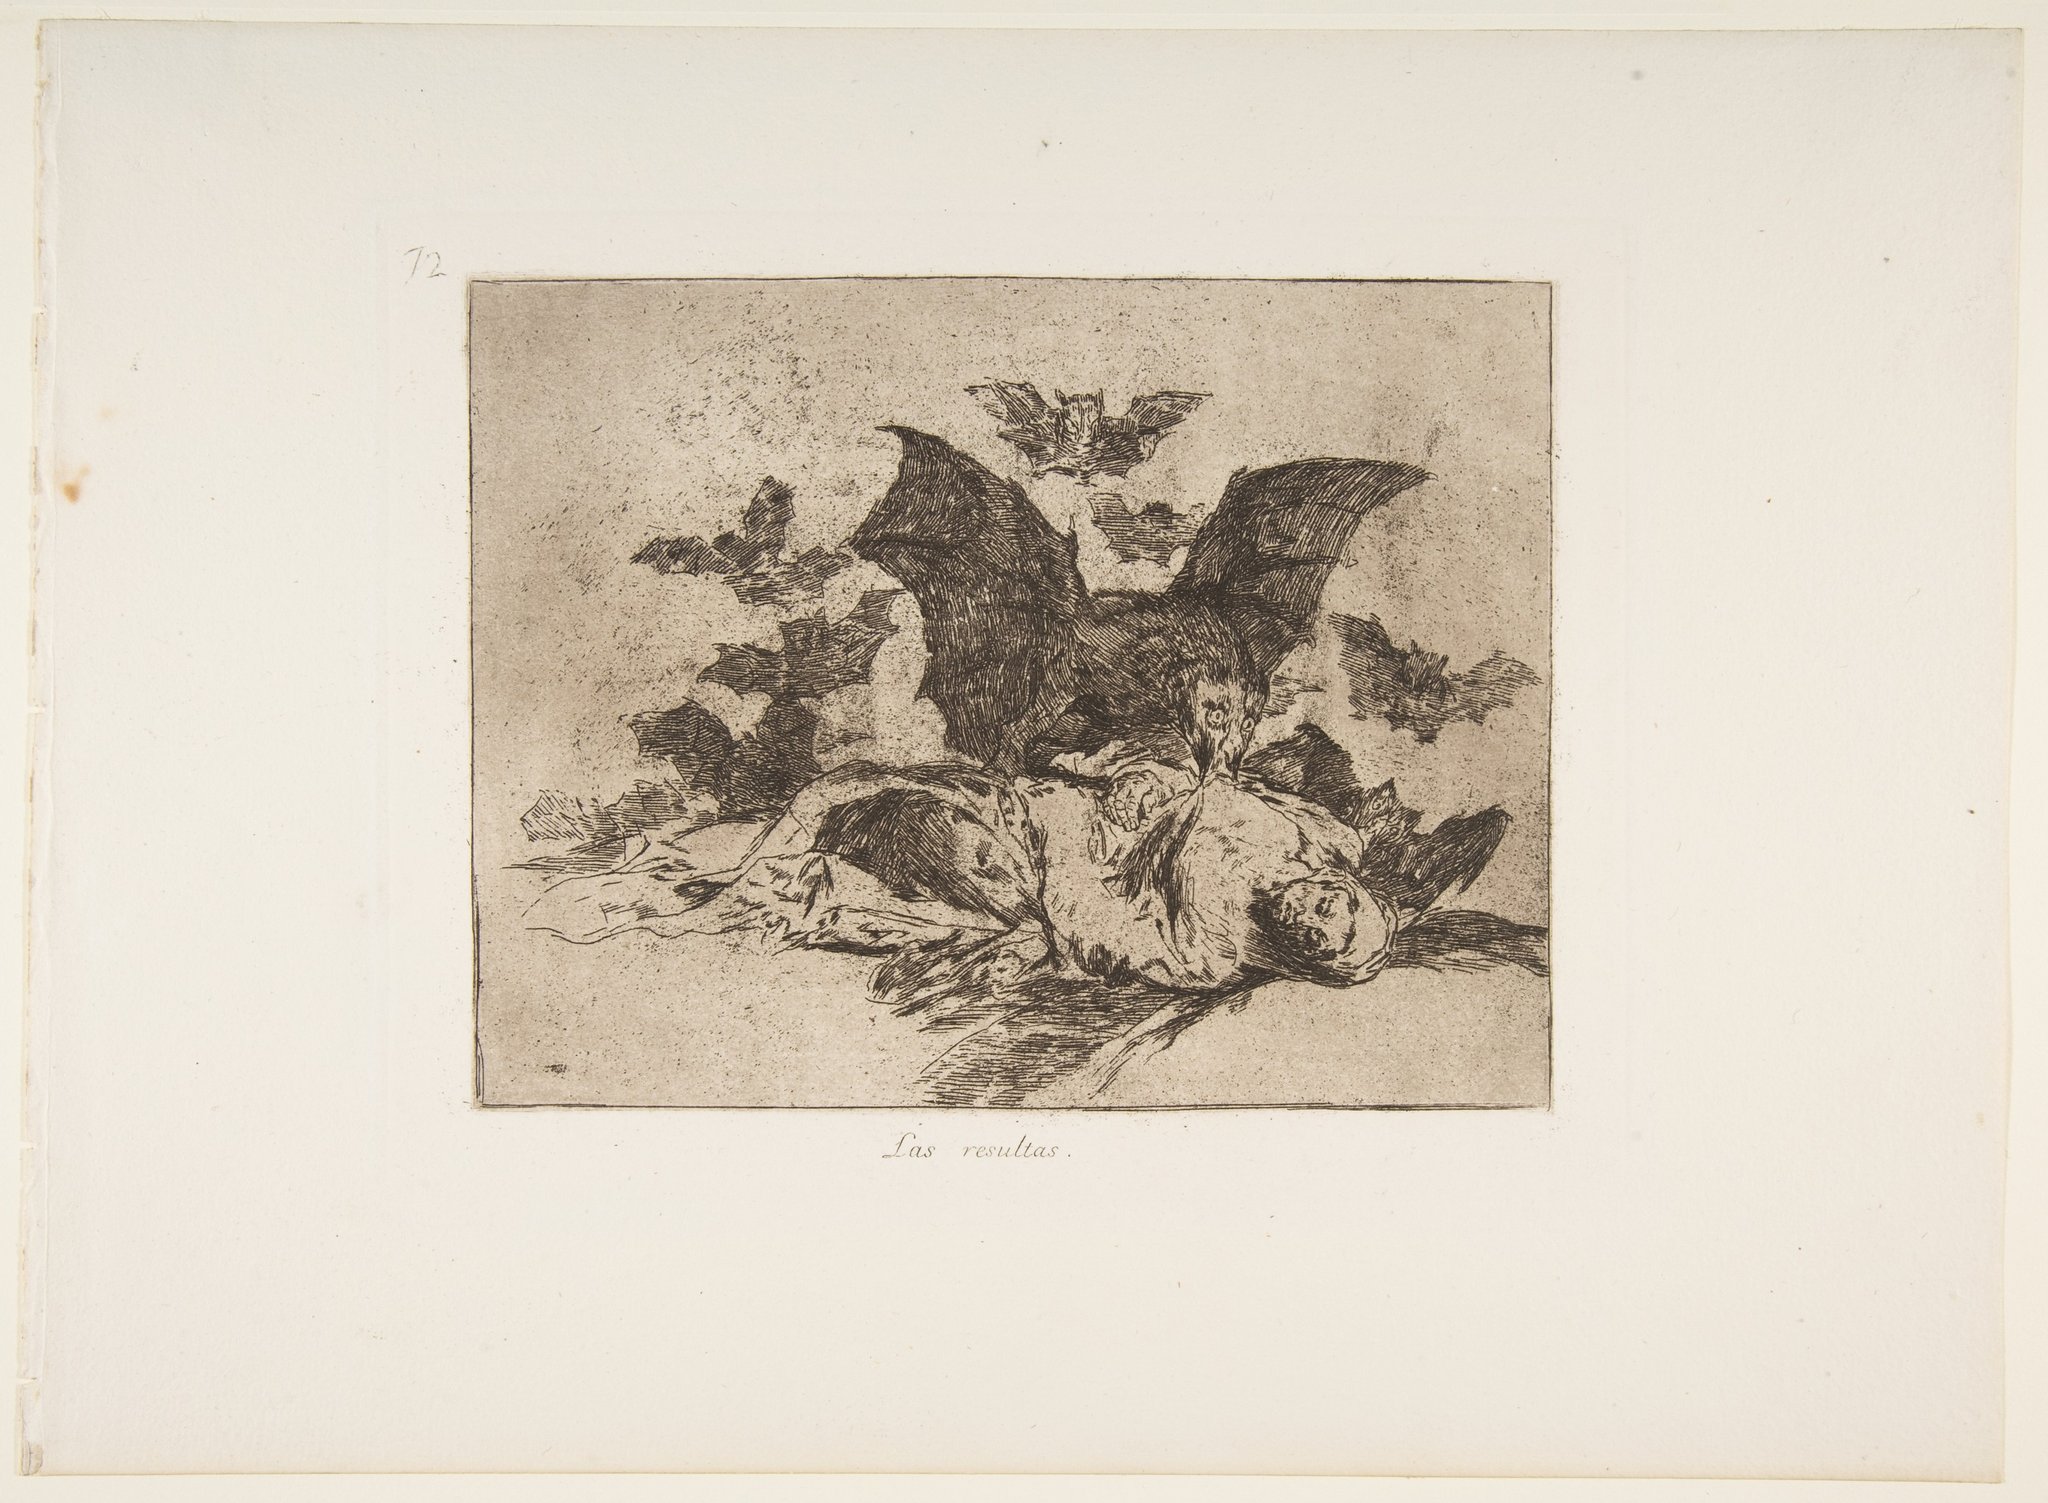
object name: print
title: Plate 72 from "The Disasters of War" (Los Desastres de la Guerra): 'The Consequences' (Las resultas)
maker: goya (francisco de goya y lucientes)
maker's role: artist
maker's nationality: spanish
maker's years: 1746-1828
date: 1814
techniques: etching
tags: bats,women